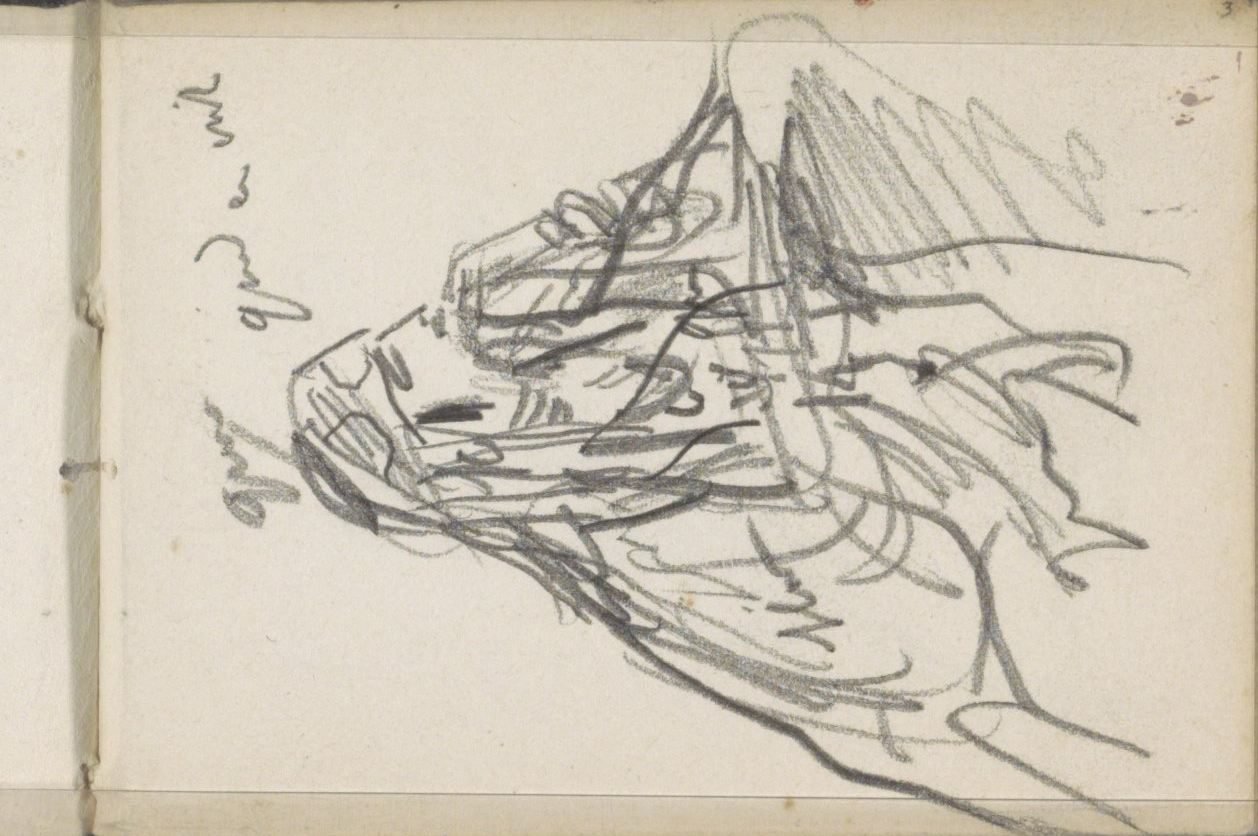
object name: sketchbook leaf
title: Algerijnse vrouw, ten halven lijve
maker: marius bauer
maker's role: draughtsman, print maker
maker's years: 1867-1932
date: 1922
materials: paper, pencil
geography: biskra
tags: adult woman, africans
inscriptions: kleurnotitie, handgeschreven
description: De vrouw draagt een sluier en steunt haar hoofd op haar arm. Pagina 3 uit een schetsboek met 32 bladen.